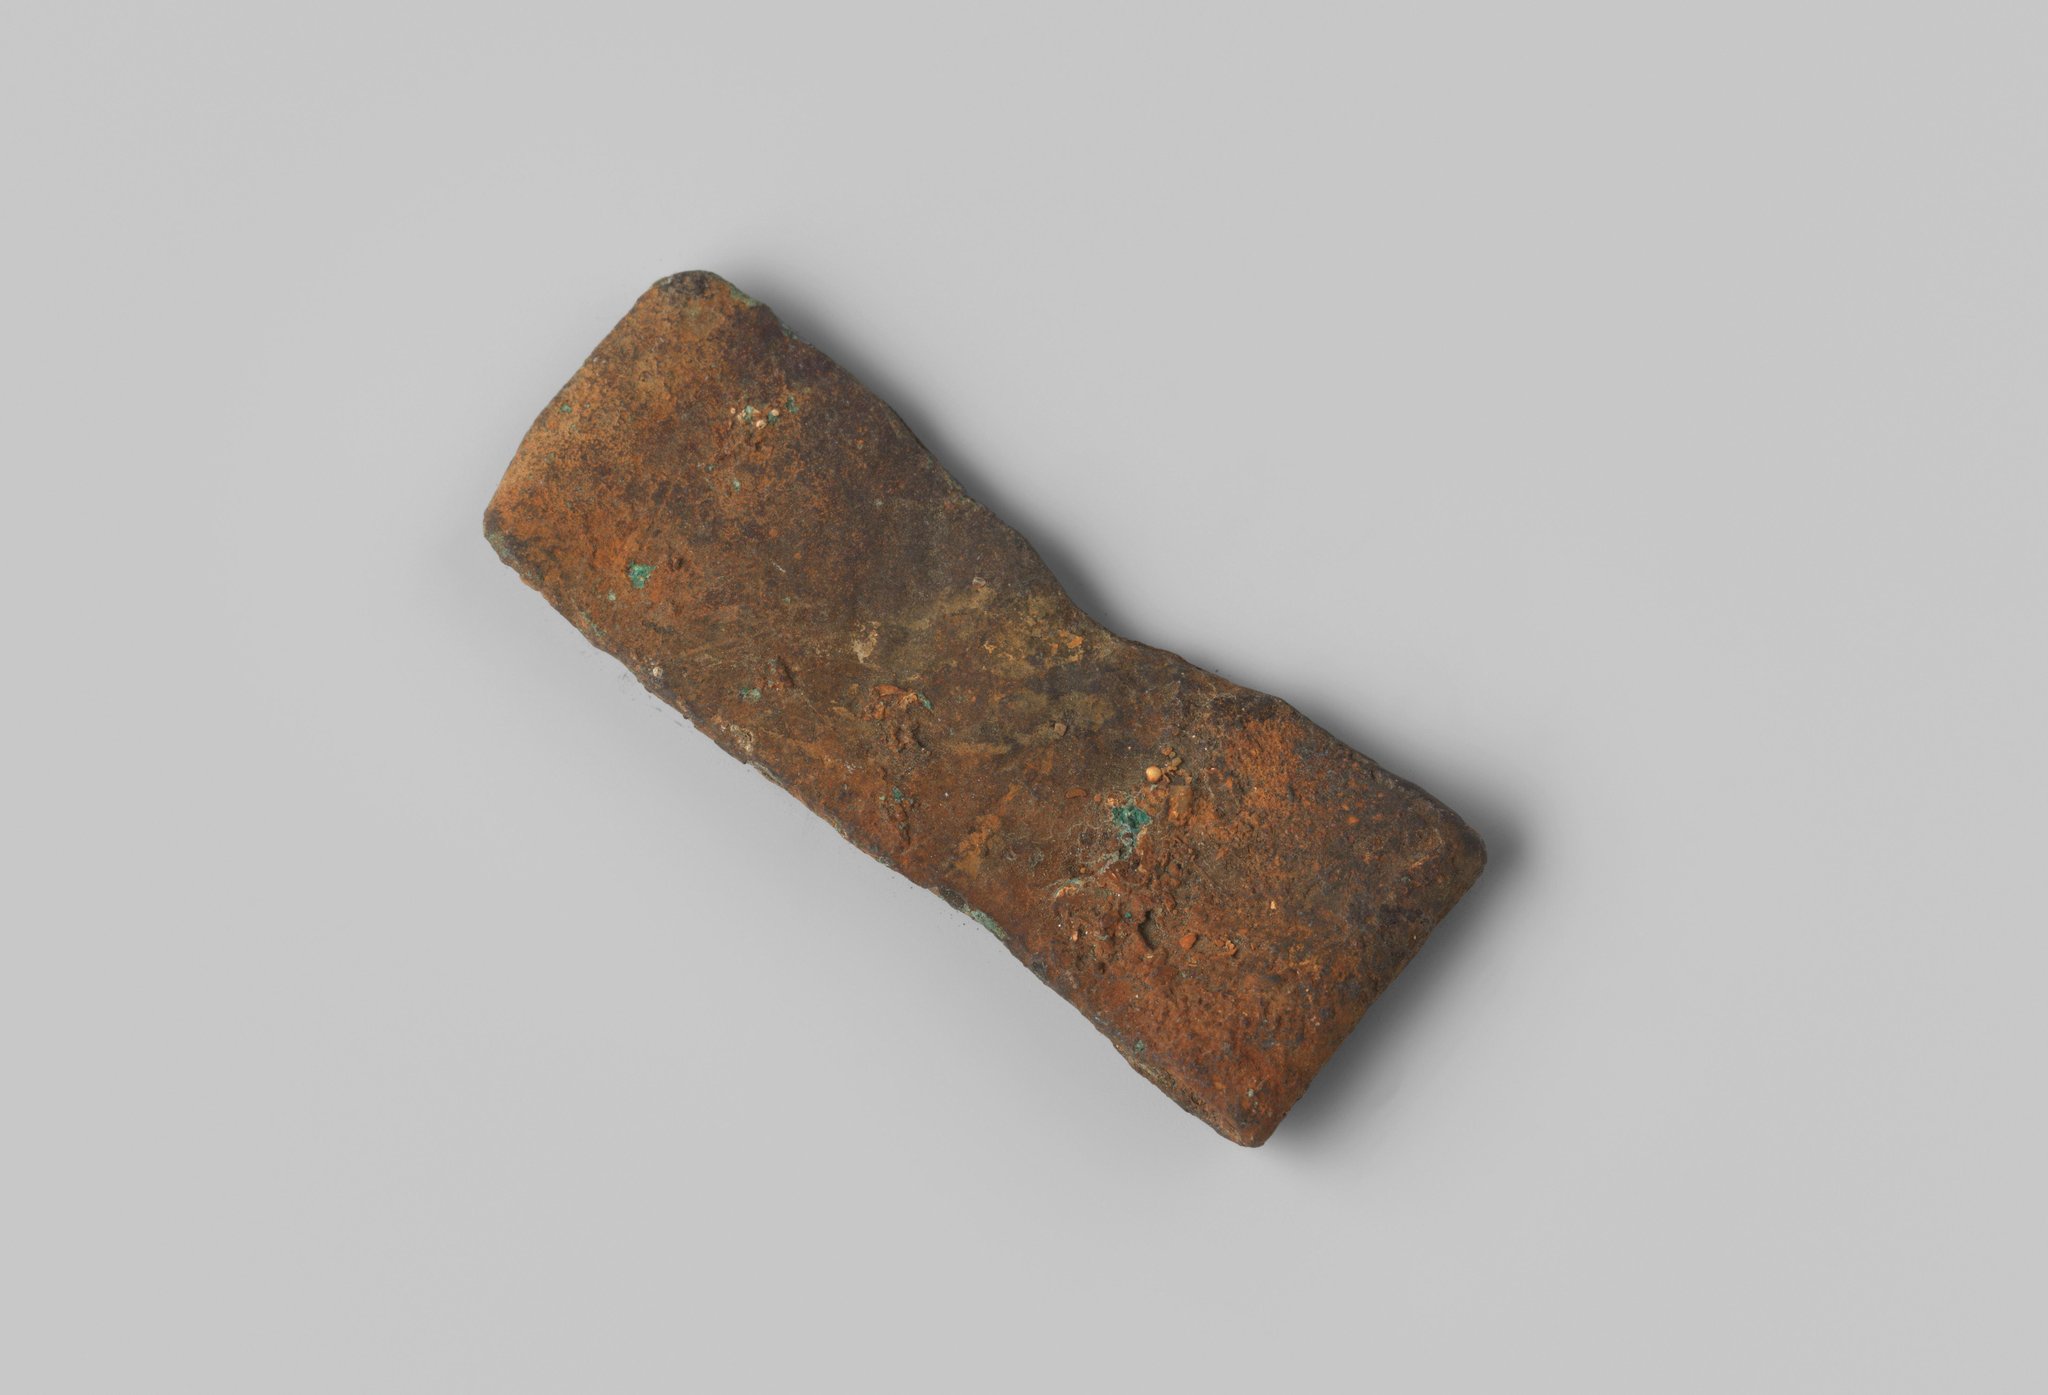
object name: firehose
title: Brandslangring uit het wrak van de Oost-Indiëvaarder Hollandia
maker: Anonymous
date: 1700-1743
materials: copper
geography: netherlands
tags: verenigde oostindische compagnie, hollandia (schip), annet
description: Firehose, fragm, id. NG 1975-20H1271a, squashed.